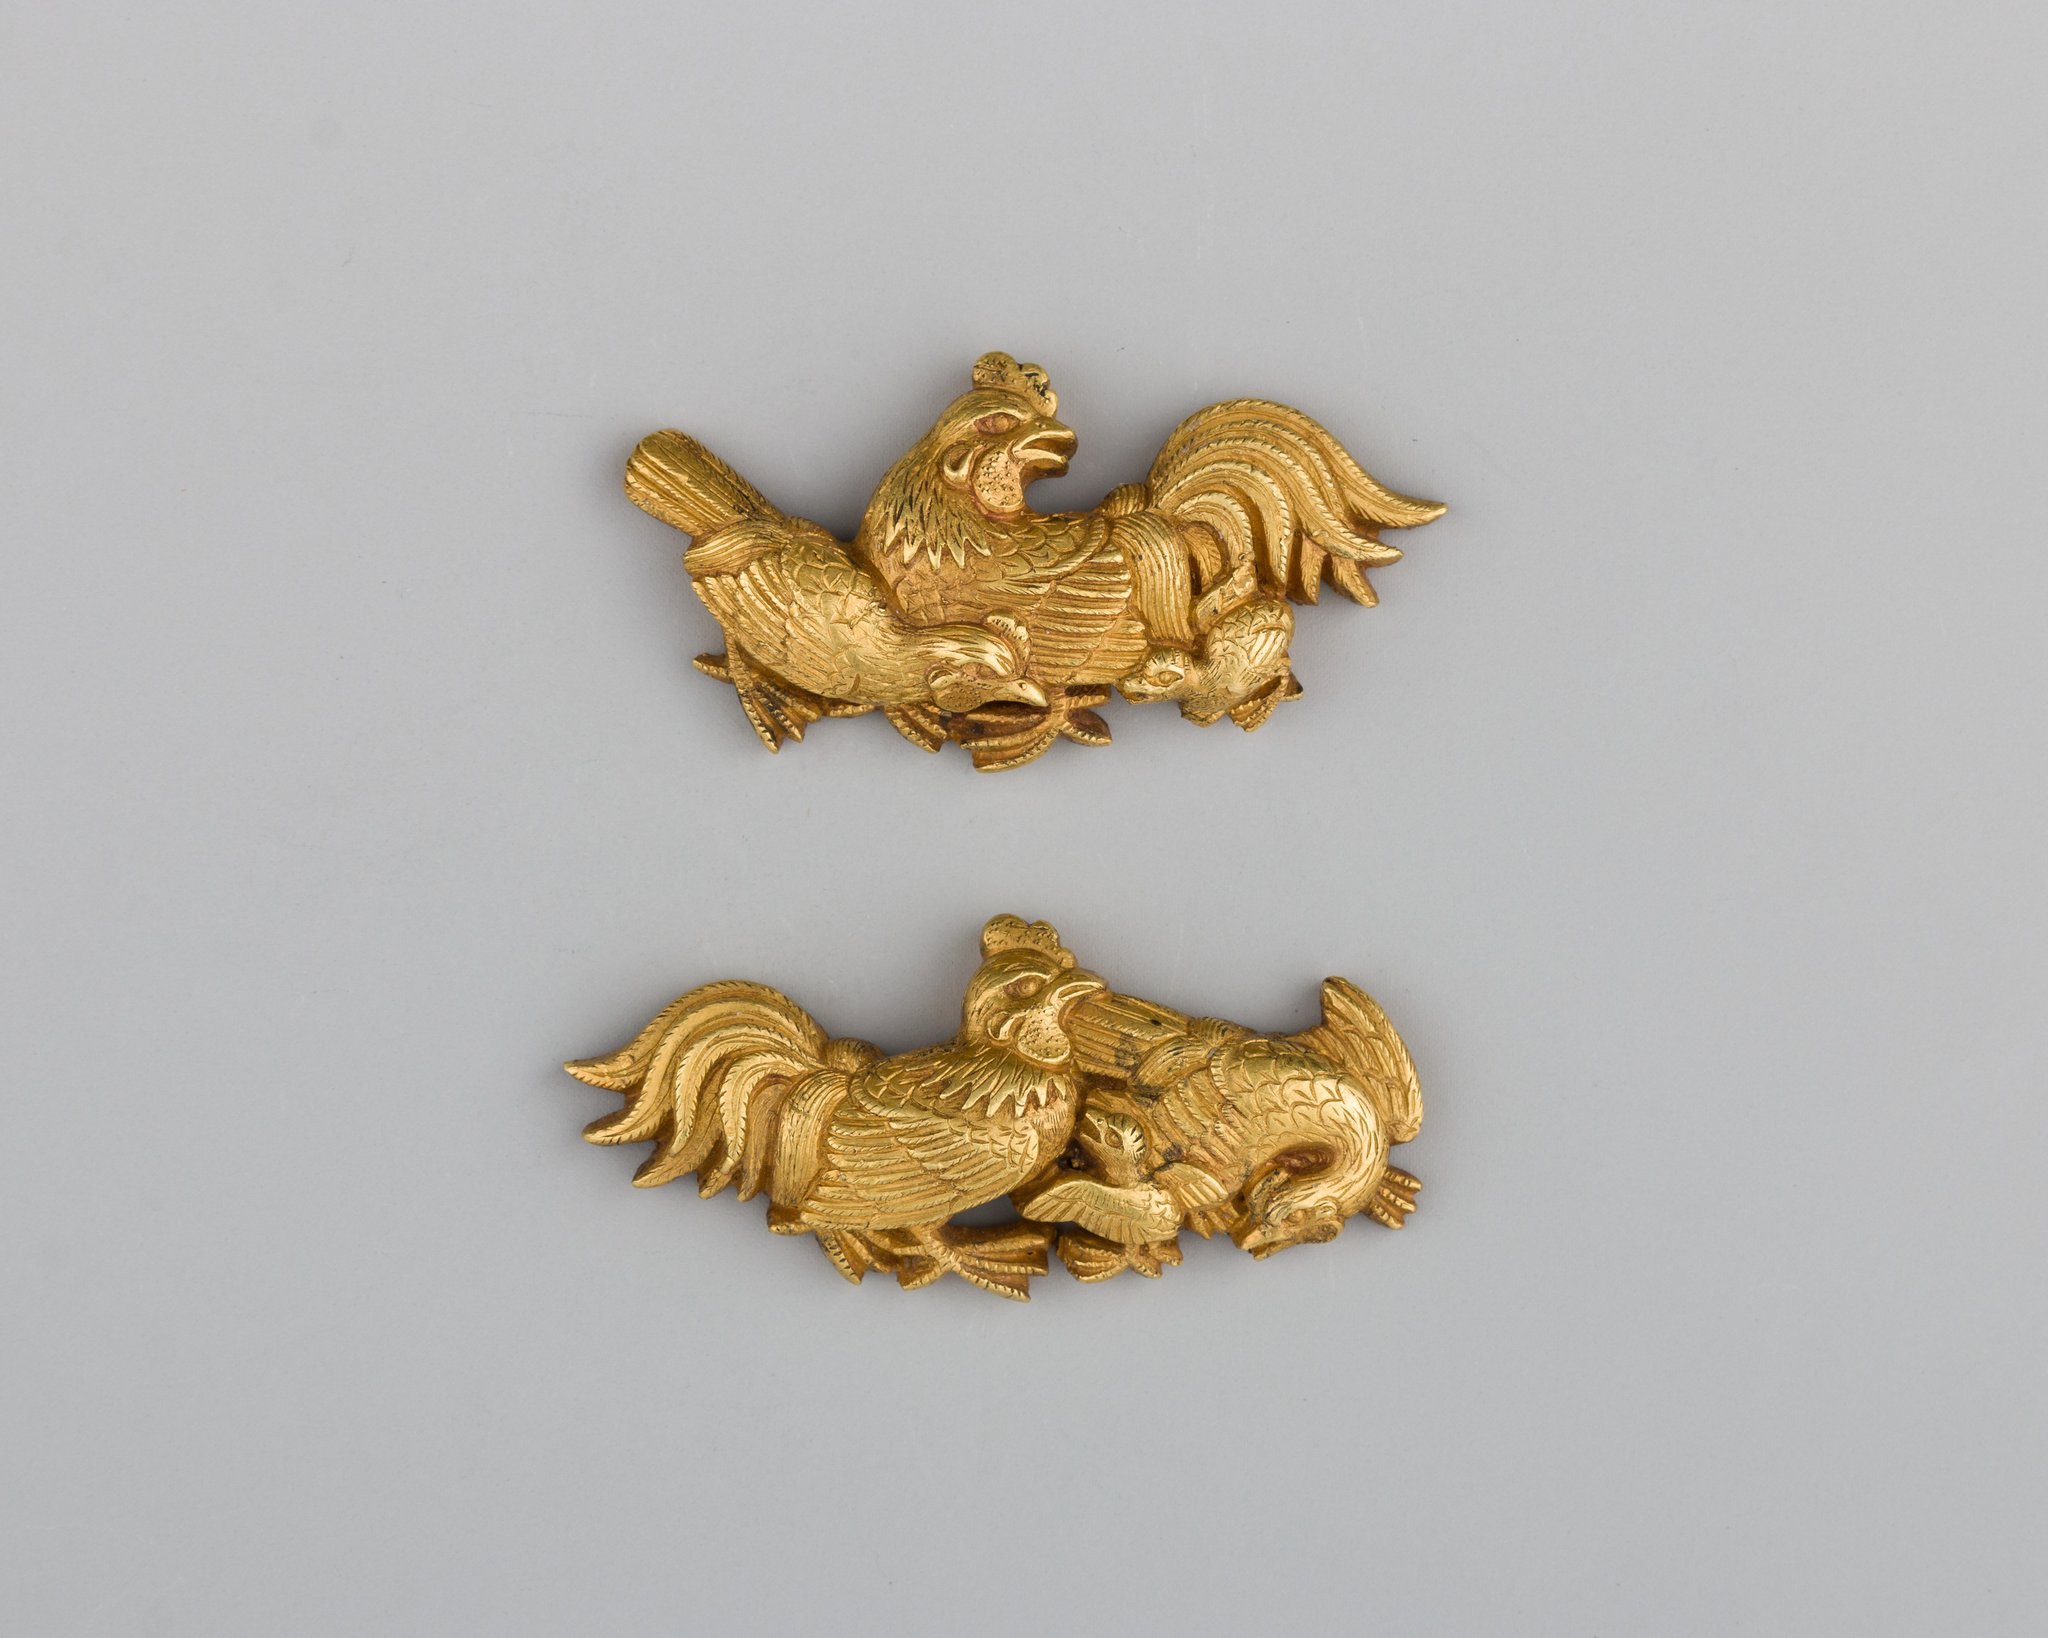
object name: pair of sword grip ornament menuki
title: Pair of Sword-Grip Ornaments (Menuki)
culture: japanese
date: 1701-1800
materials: gold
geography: japan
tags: chickens,roosters